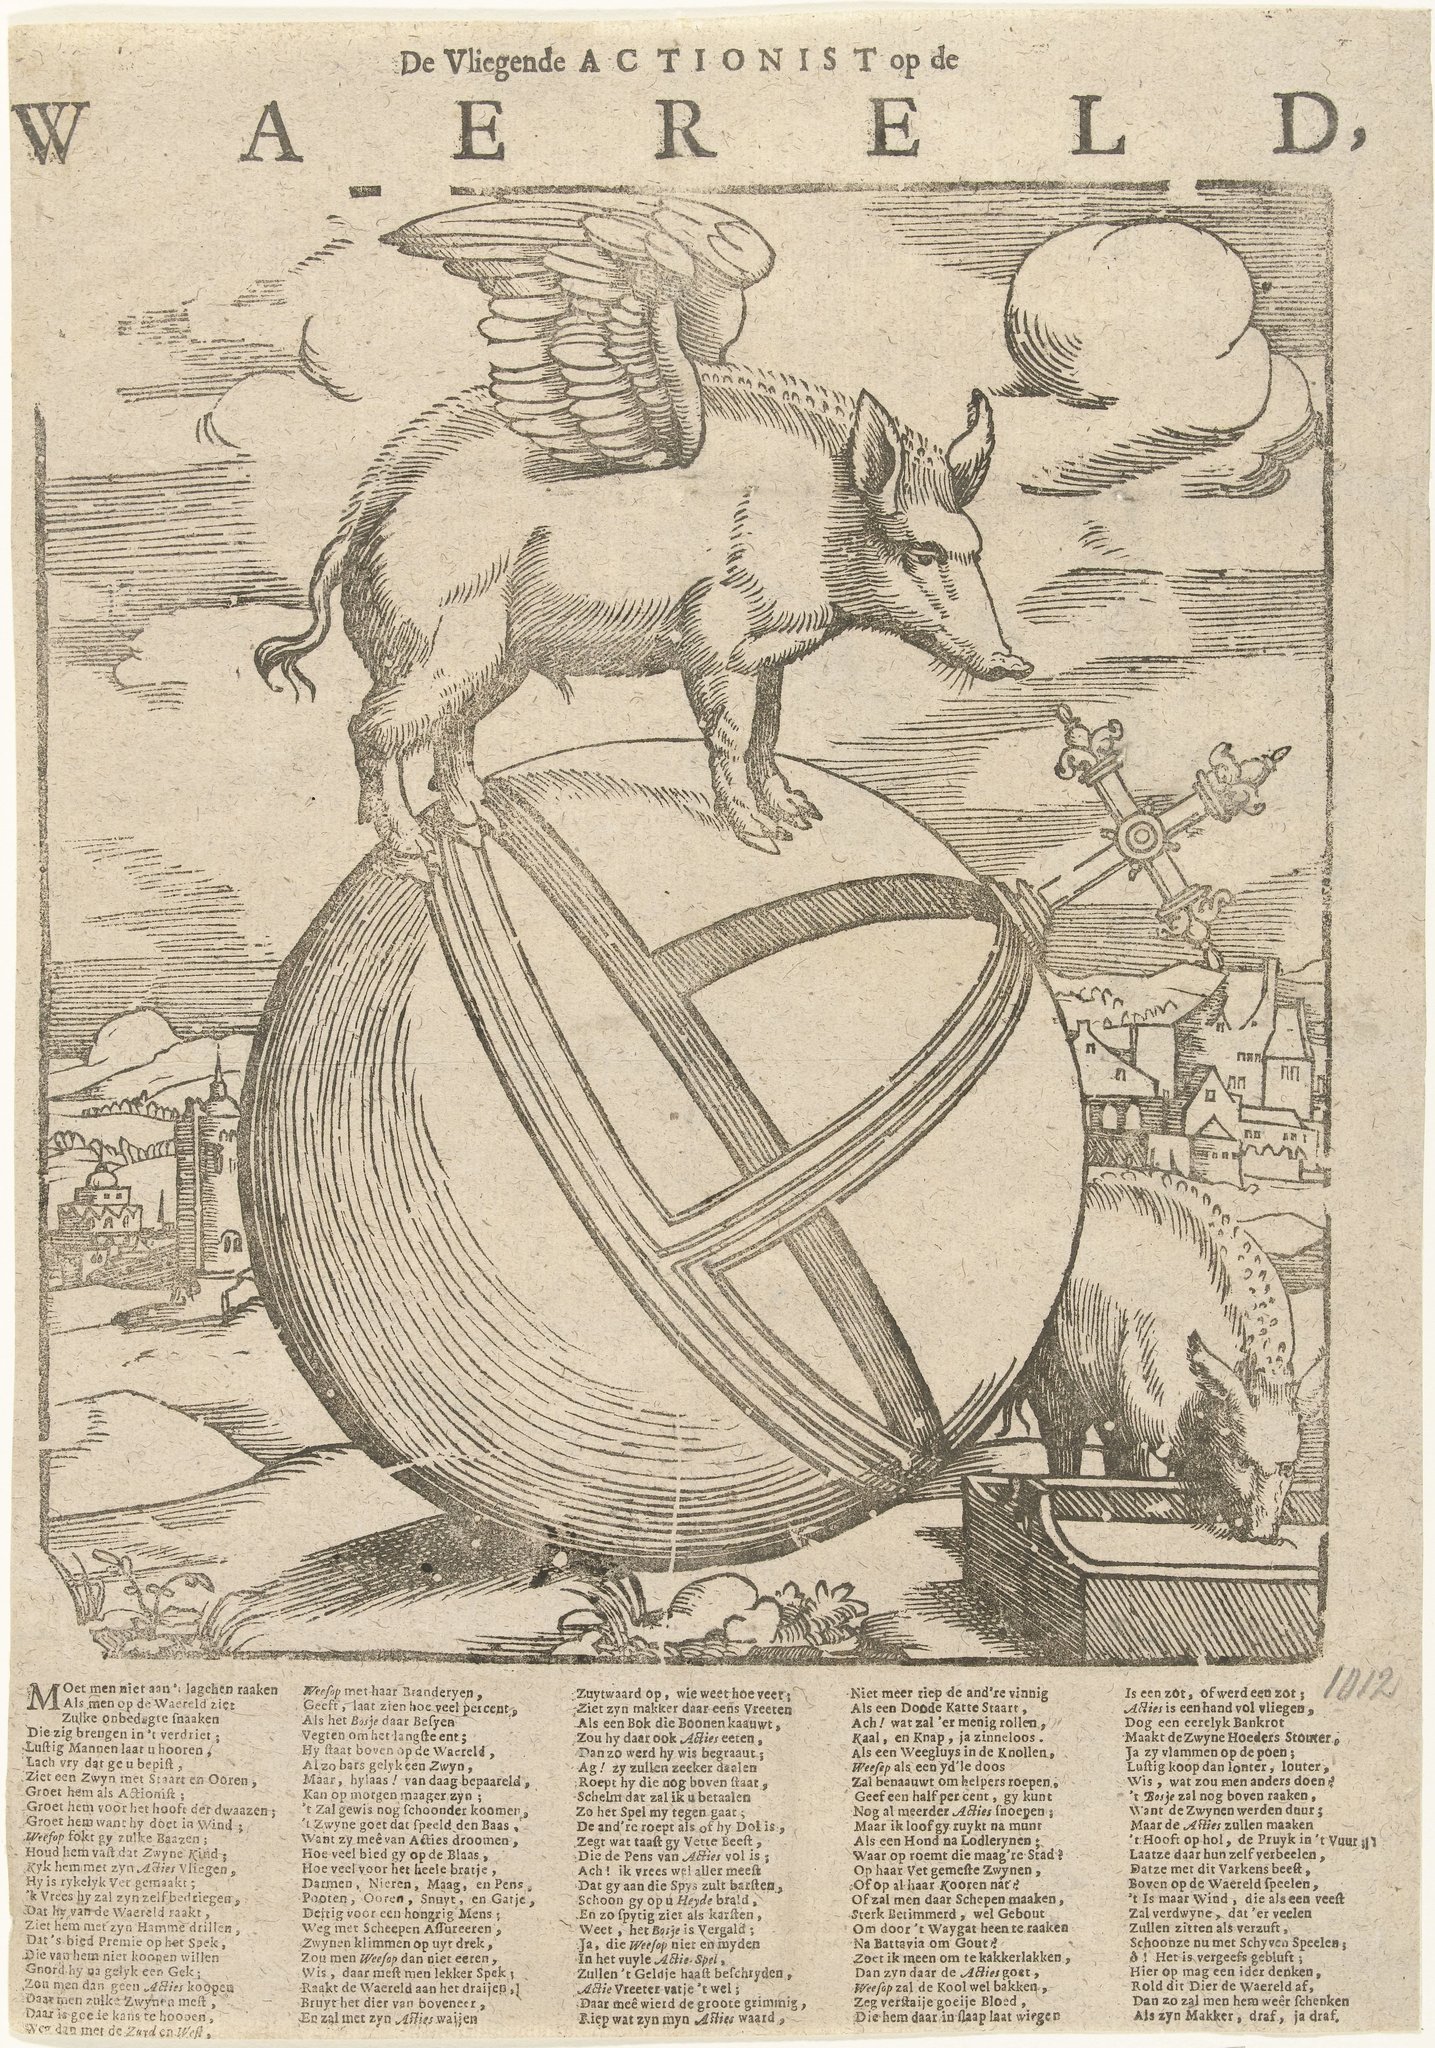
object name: cartoon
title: De Vliegende Actionist op de Waereld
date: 1520-1553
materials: paper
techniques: letterpress printing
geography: northern netherlands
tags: pig, 'mundus inversus', the reversed world, the topsy-turvy world, 'le monde bestourné'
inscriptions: collector's mark: Lugt 2228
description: De Vliegende Actionist op de Wereld. Een gevleugeld varken staande op een wereldbol met een kruis (rijksappel), rechts eet een varken uit een trog, op de achtergrond een stad. In het onderschrift een vers in vijf kolommen. Behoort tot de groep van bijprenten toegevoegd aan de serie Tafereel der Dwaasheid met spotprenten op de Windhandel of Actiehandel van 1720.